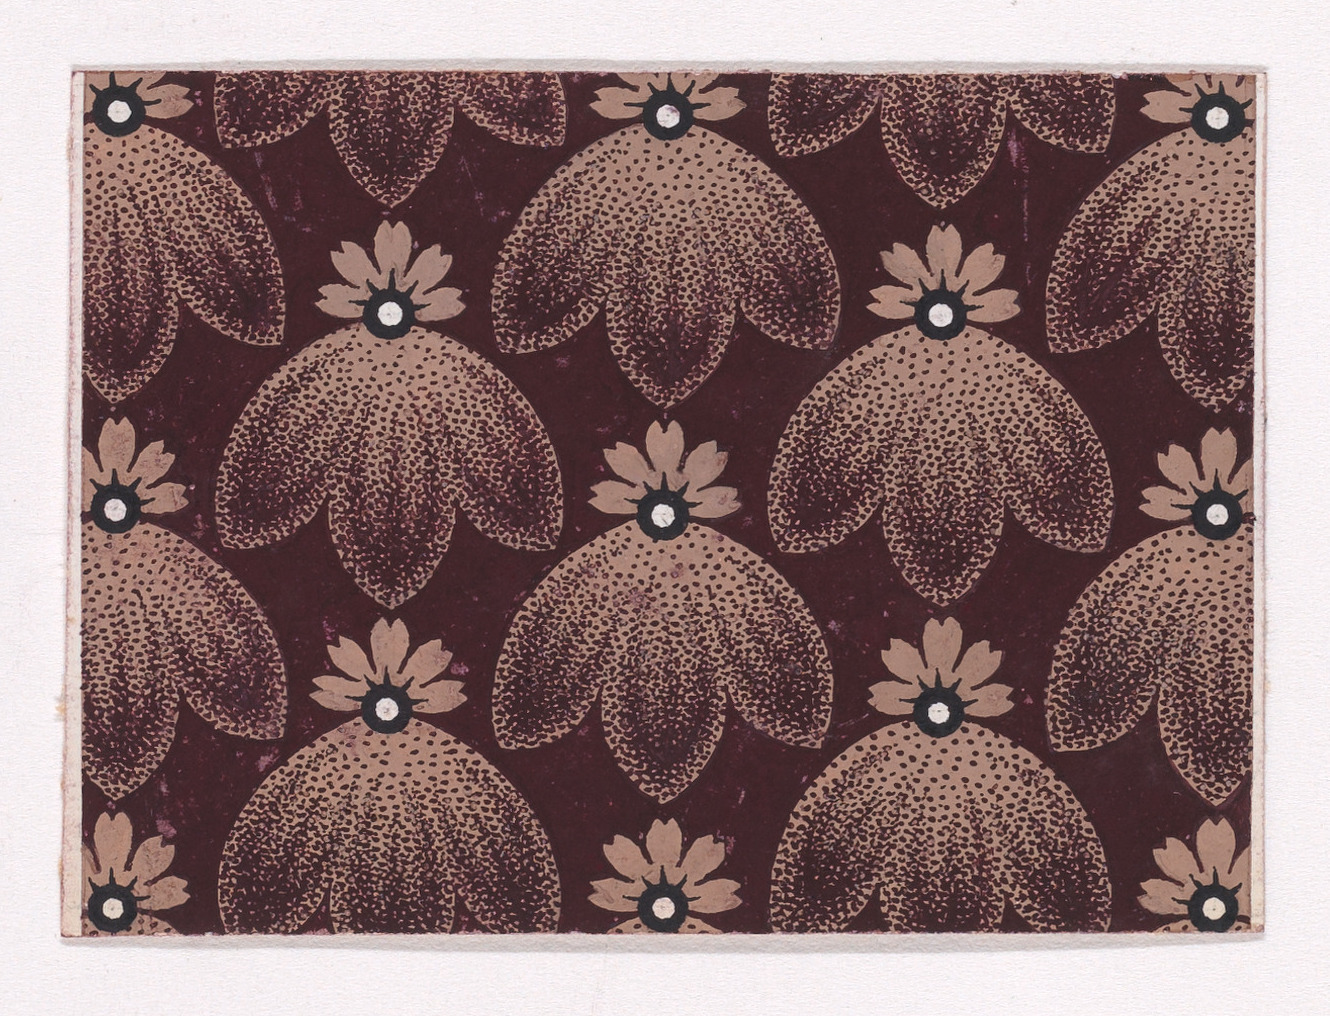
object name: drawing ornament architecture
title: Textile Design with Alternating Stylized Flowers and Leaves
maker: anonymous, alsatian, 19th century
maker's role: artist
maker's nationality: alsatian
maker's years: 1800-1900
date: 1840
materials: gouache